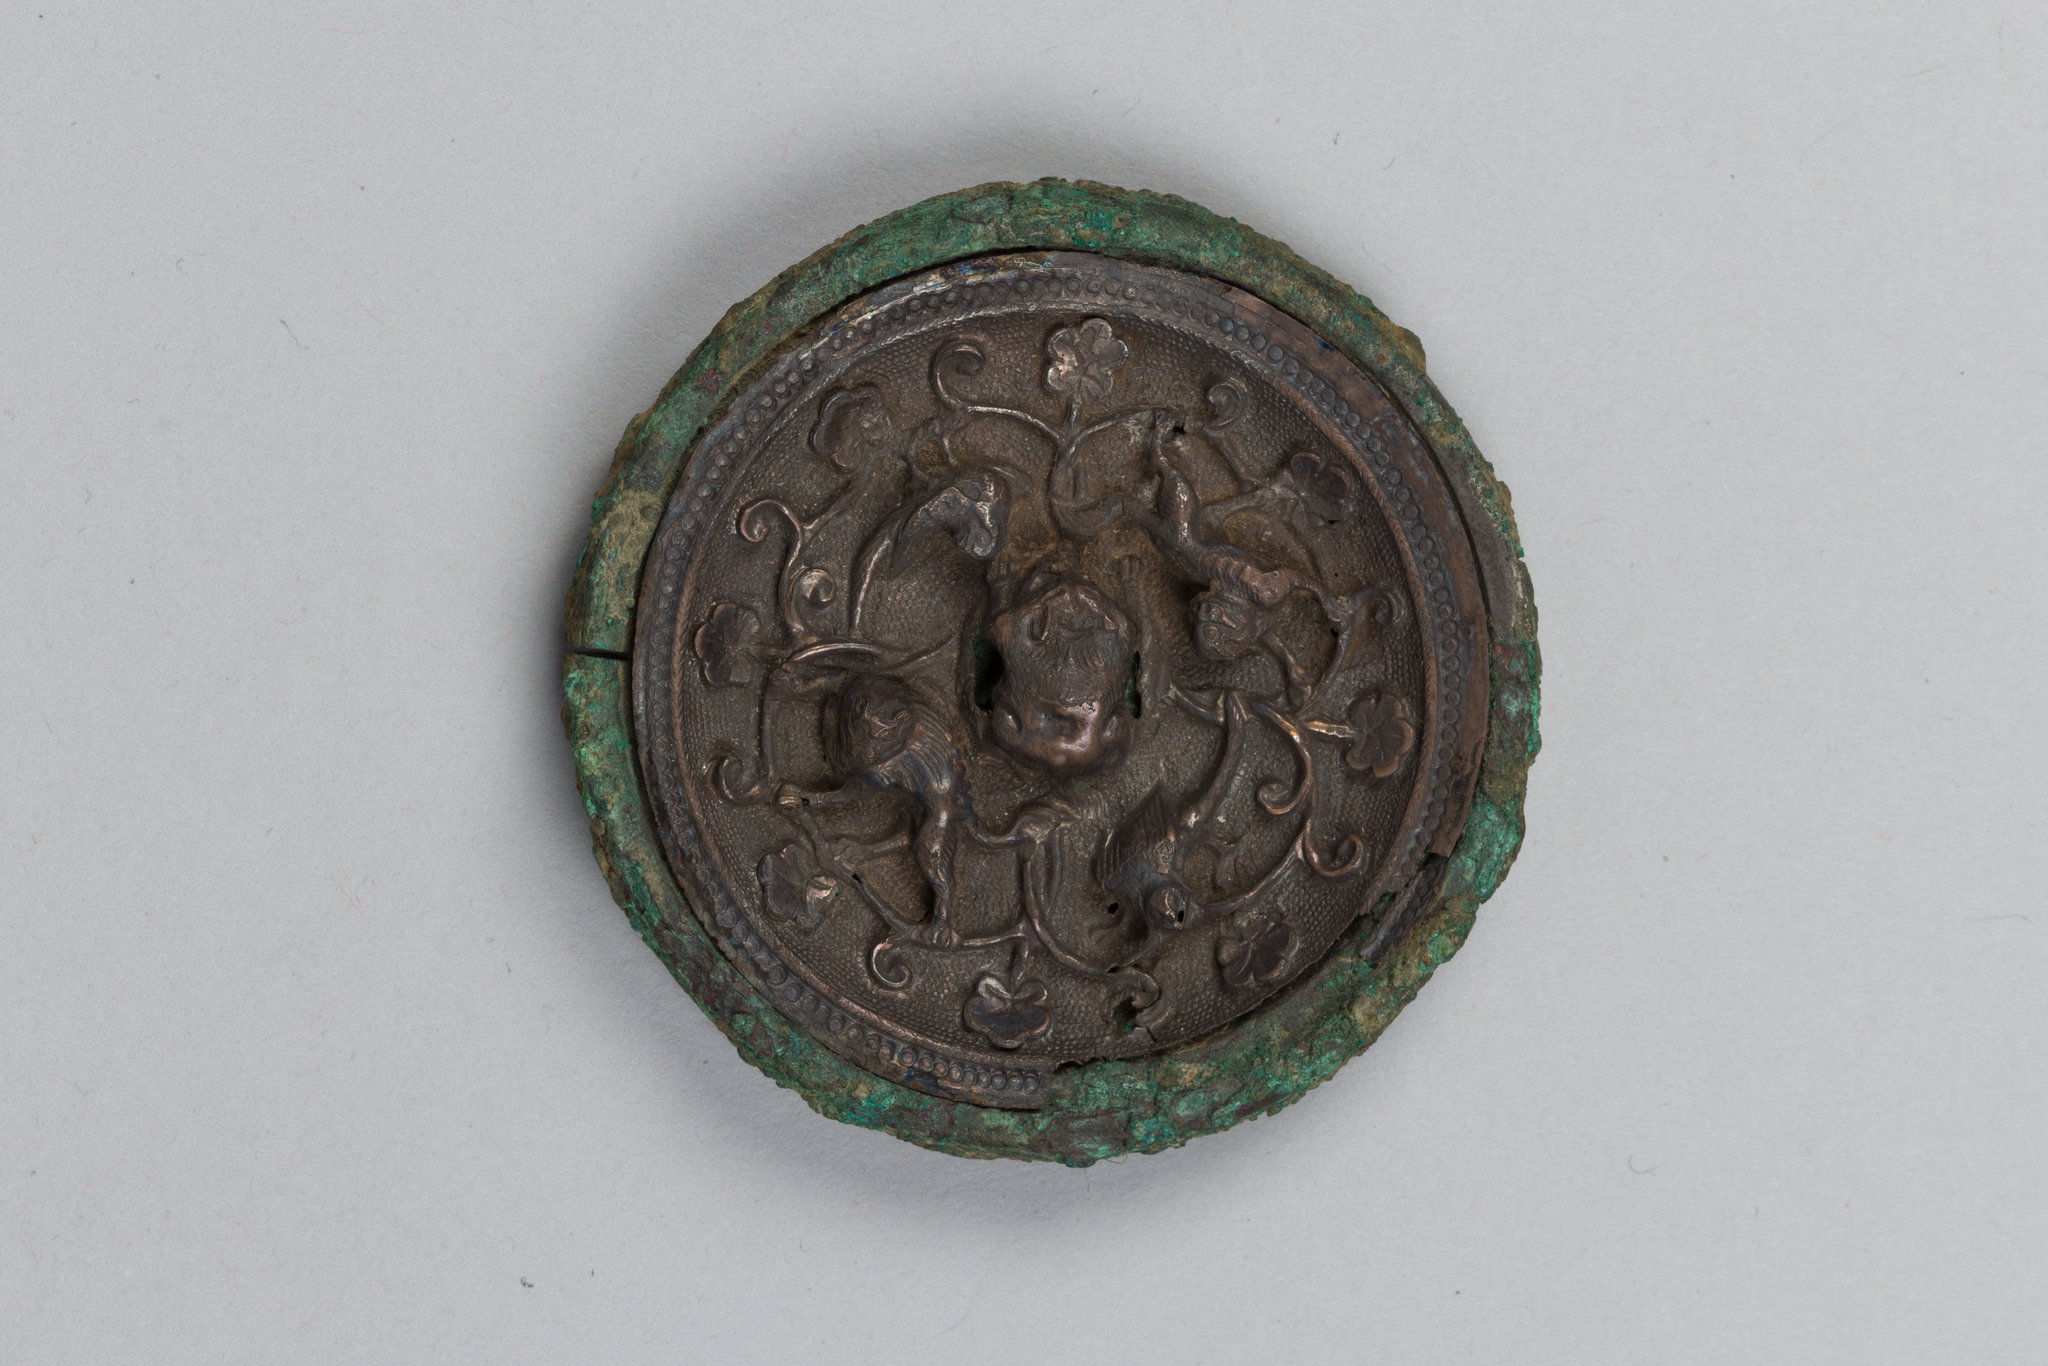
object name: mirror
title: Mirror with birds and lions amid flowers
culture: chinese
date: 701-800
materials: bronze, silver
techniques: repoussé